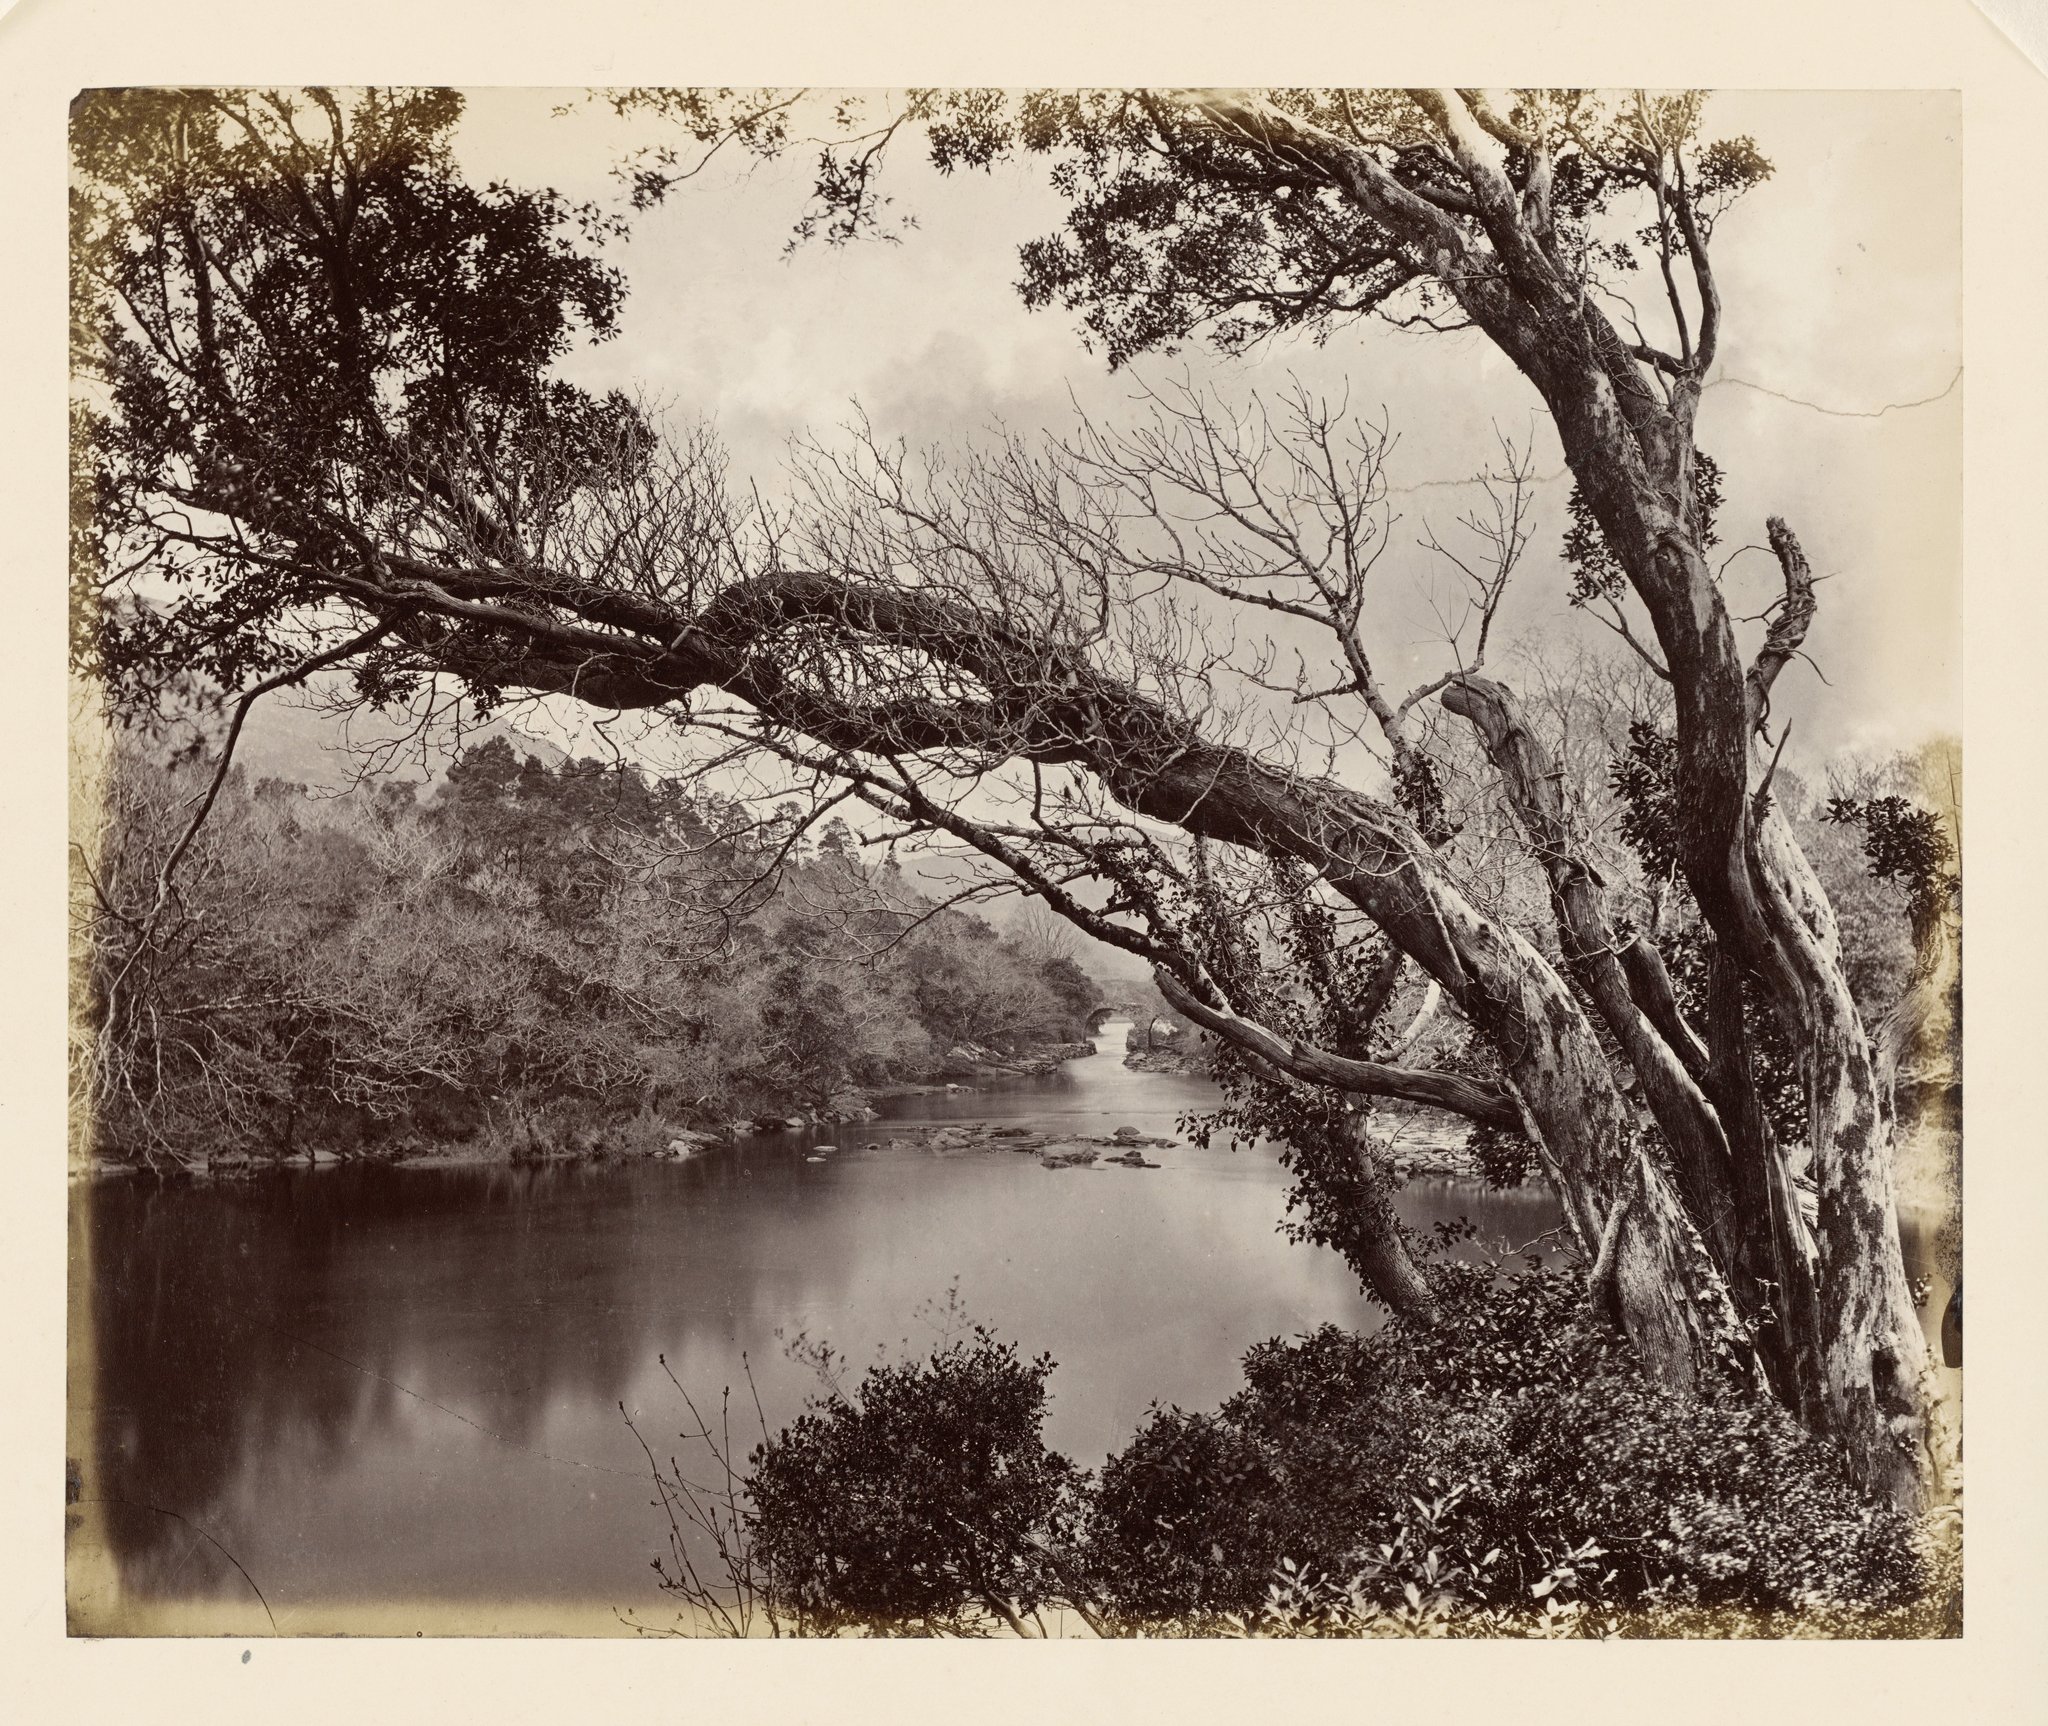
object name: photograph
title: Rivierlandschap in Groot-Brittannië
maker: john payne jennings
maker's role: fotograaf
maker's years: 1843-1926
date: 1877-1887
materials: cardboard, paper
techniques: albumen print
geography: great britain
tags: river, great britain